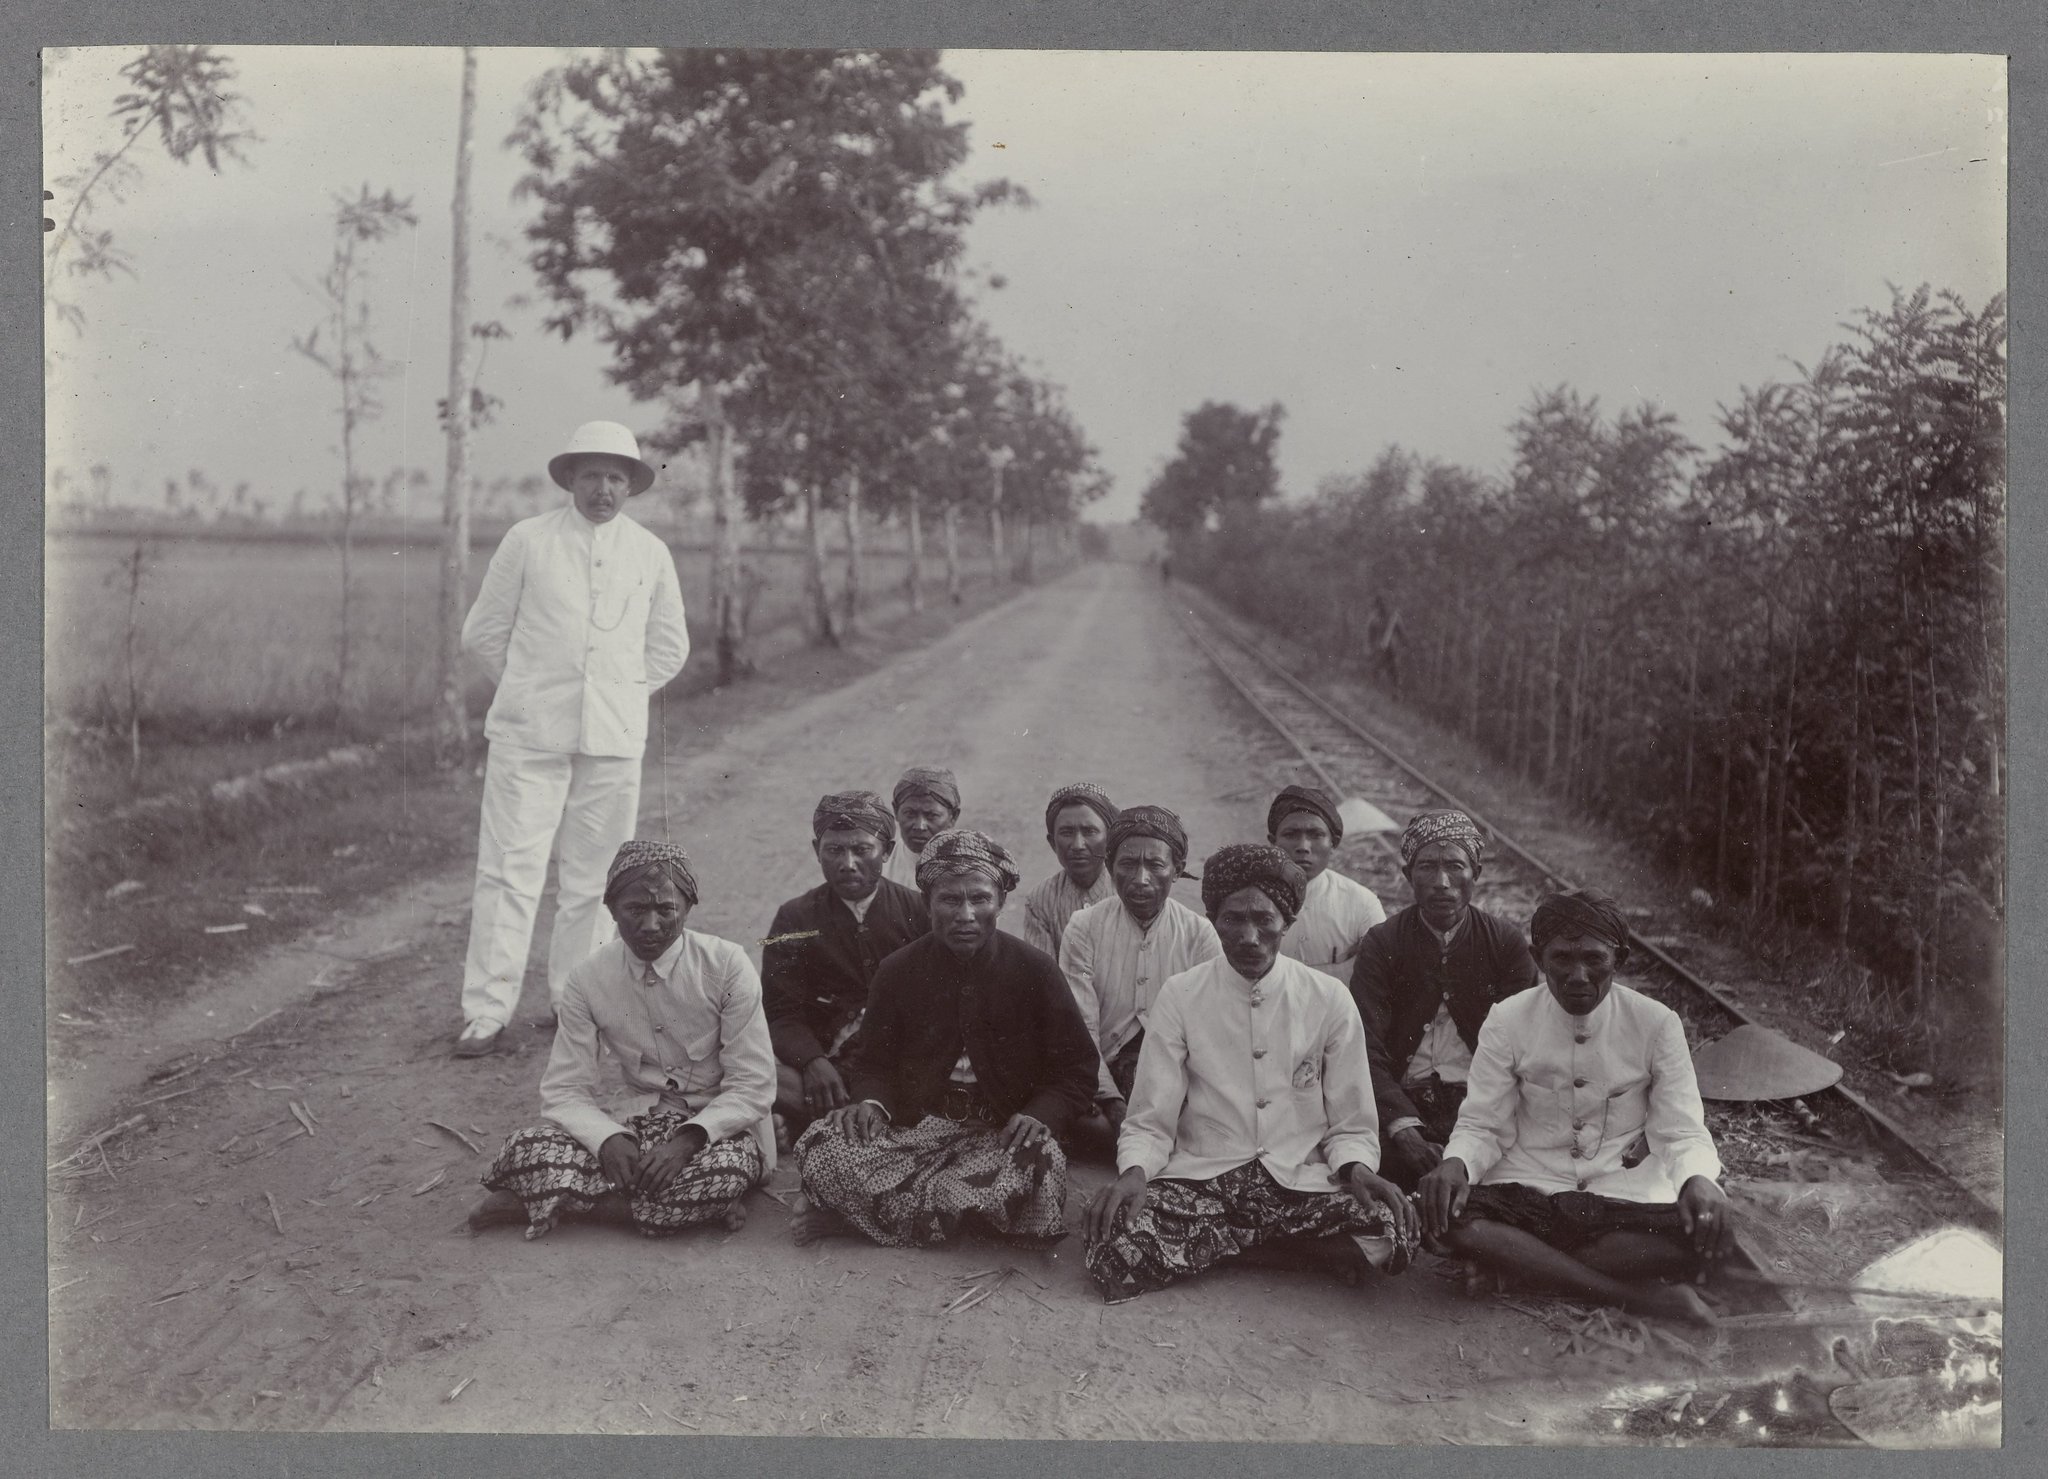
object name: photograph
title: Opzichter met werknemers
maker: Anonymous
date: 1900-1919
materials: photographic support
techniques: collodion silver print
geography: comal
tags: colonial system, plantation, director, boss (in modern industry), (non-fruit) products of plants or trees: sugarcane, industrial structures (+ men (labourers))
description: Een Europese opzichter staande bij een groep op de grond zittende Javaanse werknemers. Rechts een smalspoor en velden suikerriet. Onderdeel van het fotoalbum van de Tjomal suikerfabriek in de periode ca. 1900-1919.